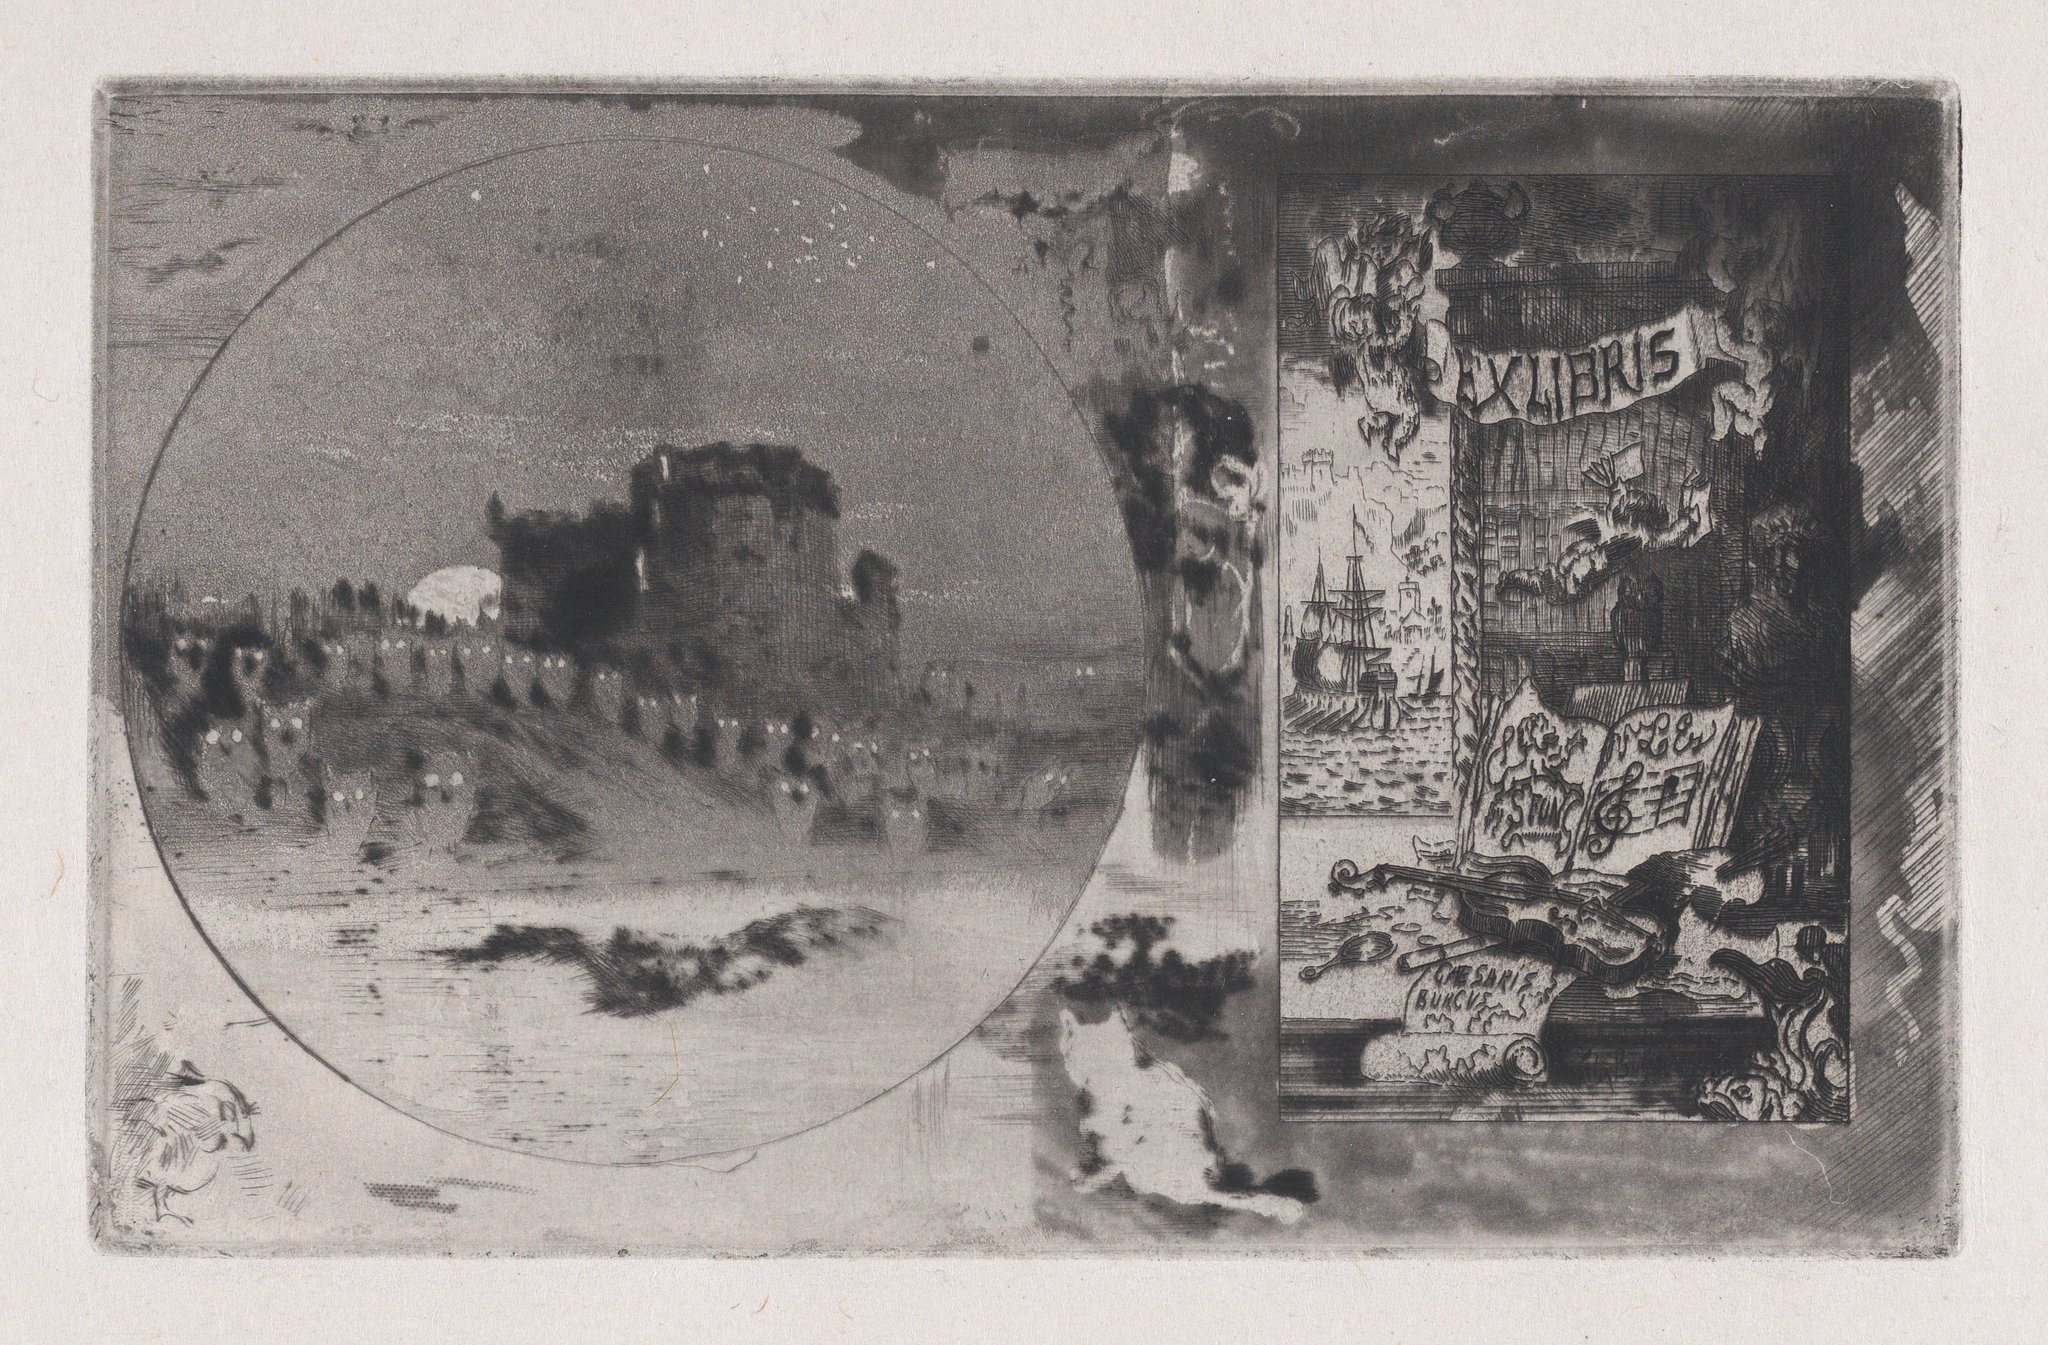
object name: print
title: The Owl's Château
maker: félix-hilaire buhot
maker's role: artist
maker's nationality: french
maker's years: 1847-1898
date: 1867-1898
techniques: aquatint, drypoint, etching, roulette